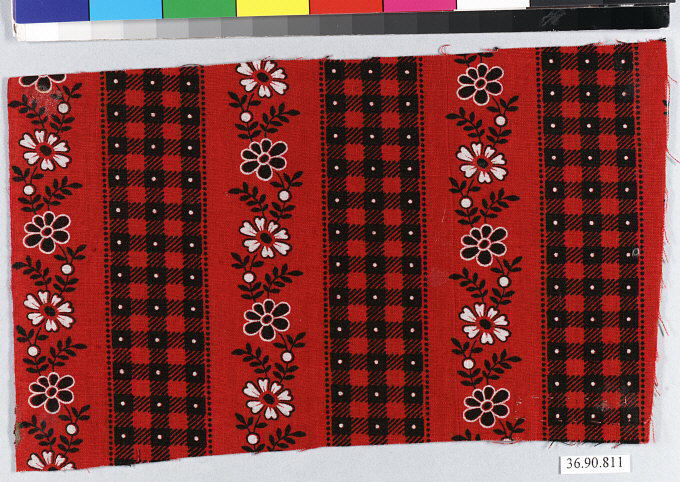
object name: piece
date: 1867-1900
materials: cotton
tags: flowers,leaves